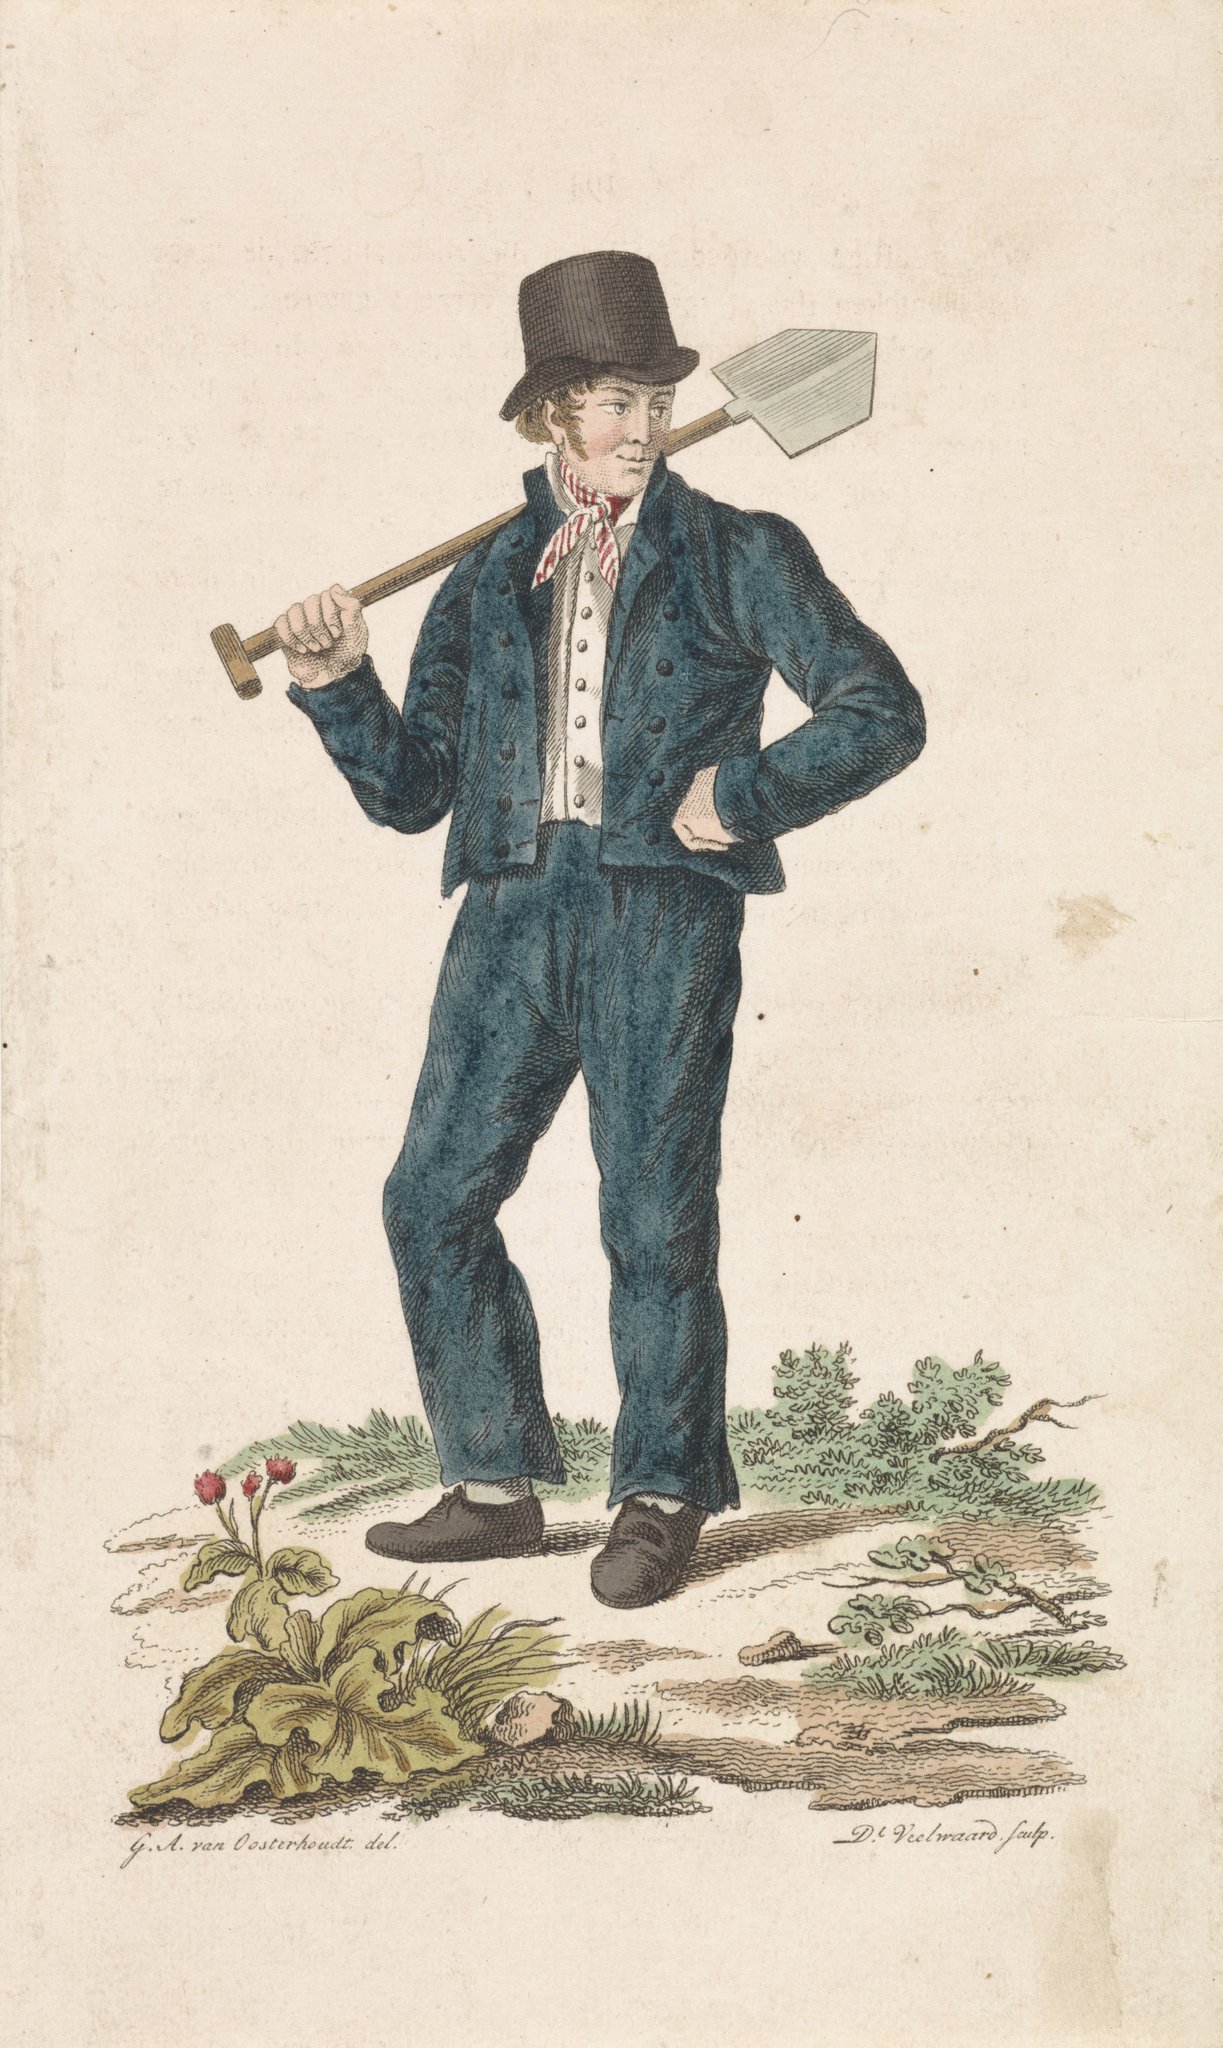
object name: print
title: Man met een spade over zijn schouder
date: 1802-1851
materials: paper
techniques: etching, hand coloring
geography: amsterdam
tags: agricultural implements: spade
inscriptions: collector's mark: Lugt 2228